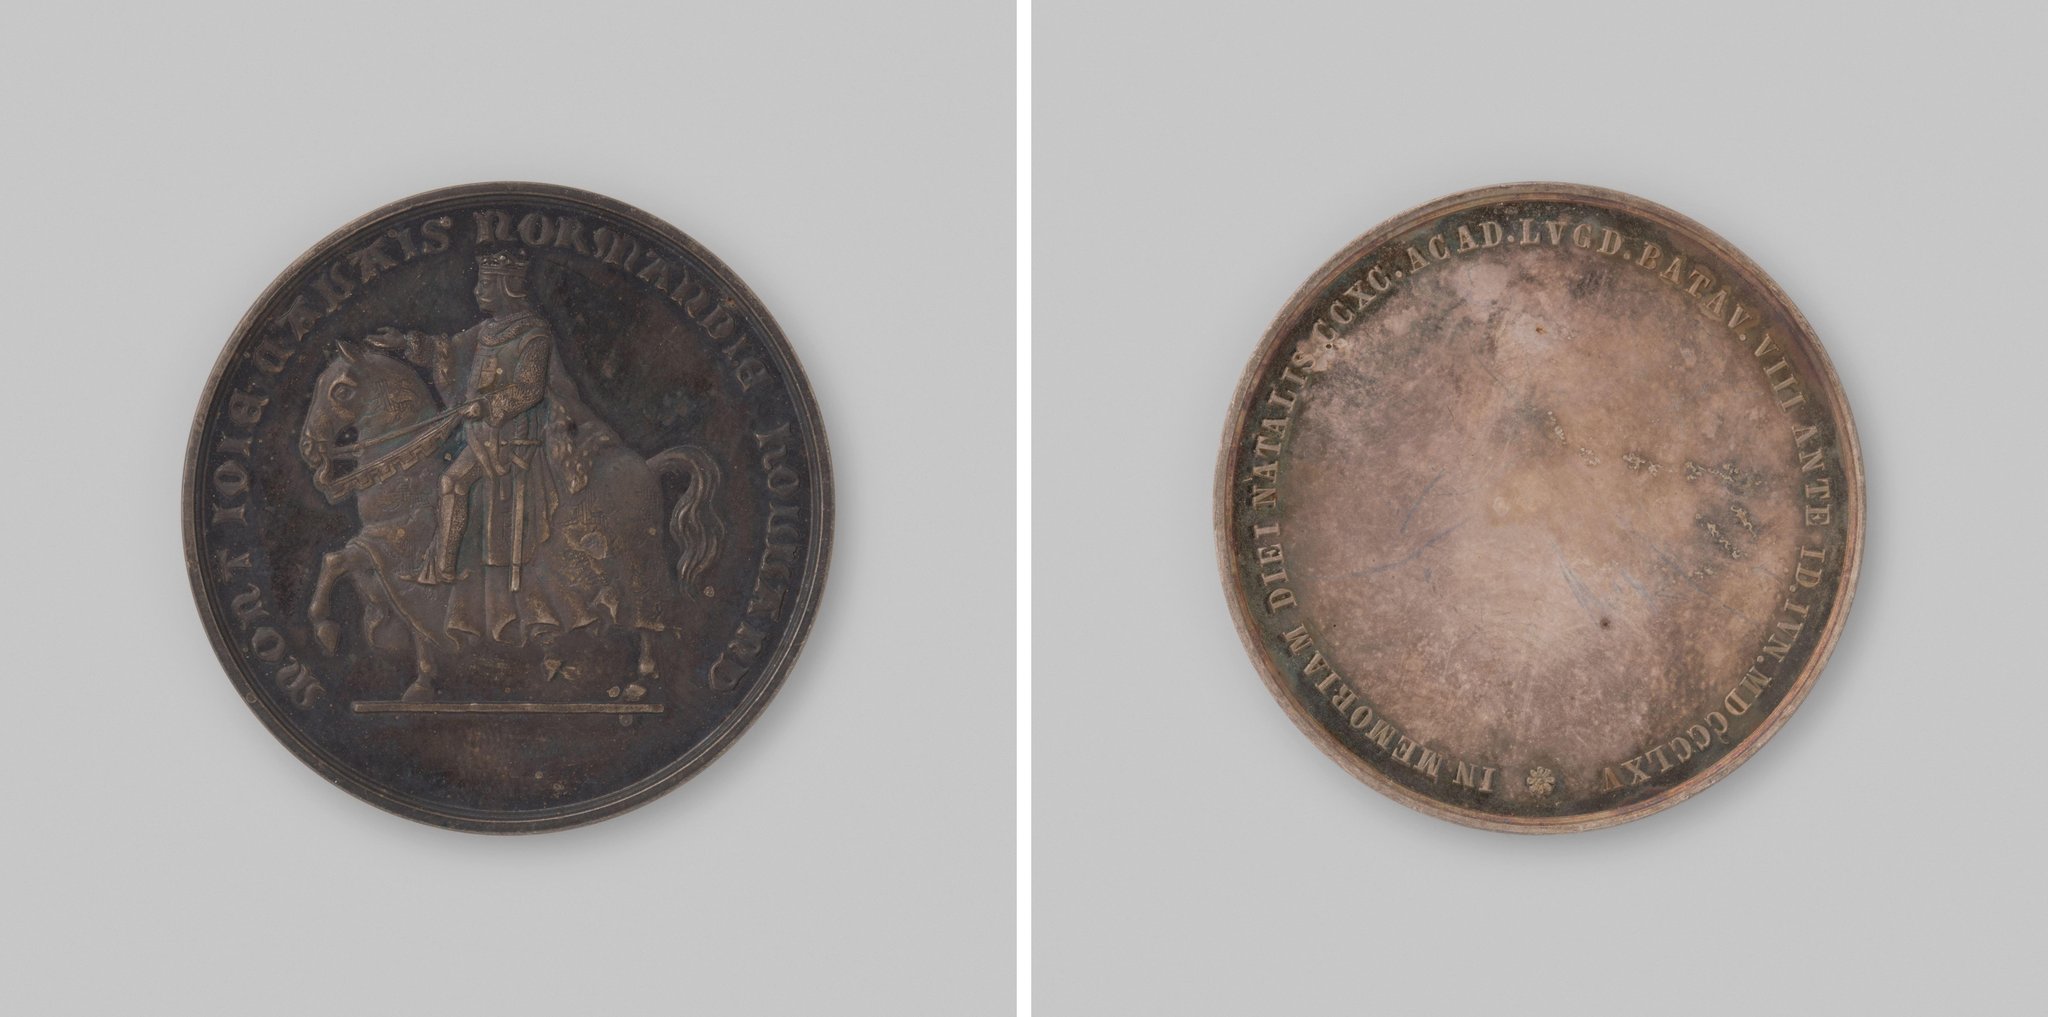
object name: history medal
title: Gemaskerde optocht door de studenten, ter herdenking van jonker Willem, graaf van Oostervant, ter ere van de 290e stichtingsdag van de Universiteit van Leiden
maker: david van der kellen (1804-1879)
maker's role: die cutter, draughtsman, print maker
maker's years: 1804-1879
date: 1865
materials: silver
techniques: striking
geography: utrecht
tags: holland en zeeland willem vi van henegouwen, leiden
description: Zilveren penning. Voorzijde: man te paard binnen omschrift in Gothisch schrift. Keerzijde: blanco veld binnen omschrift